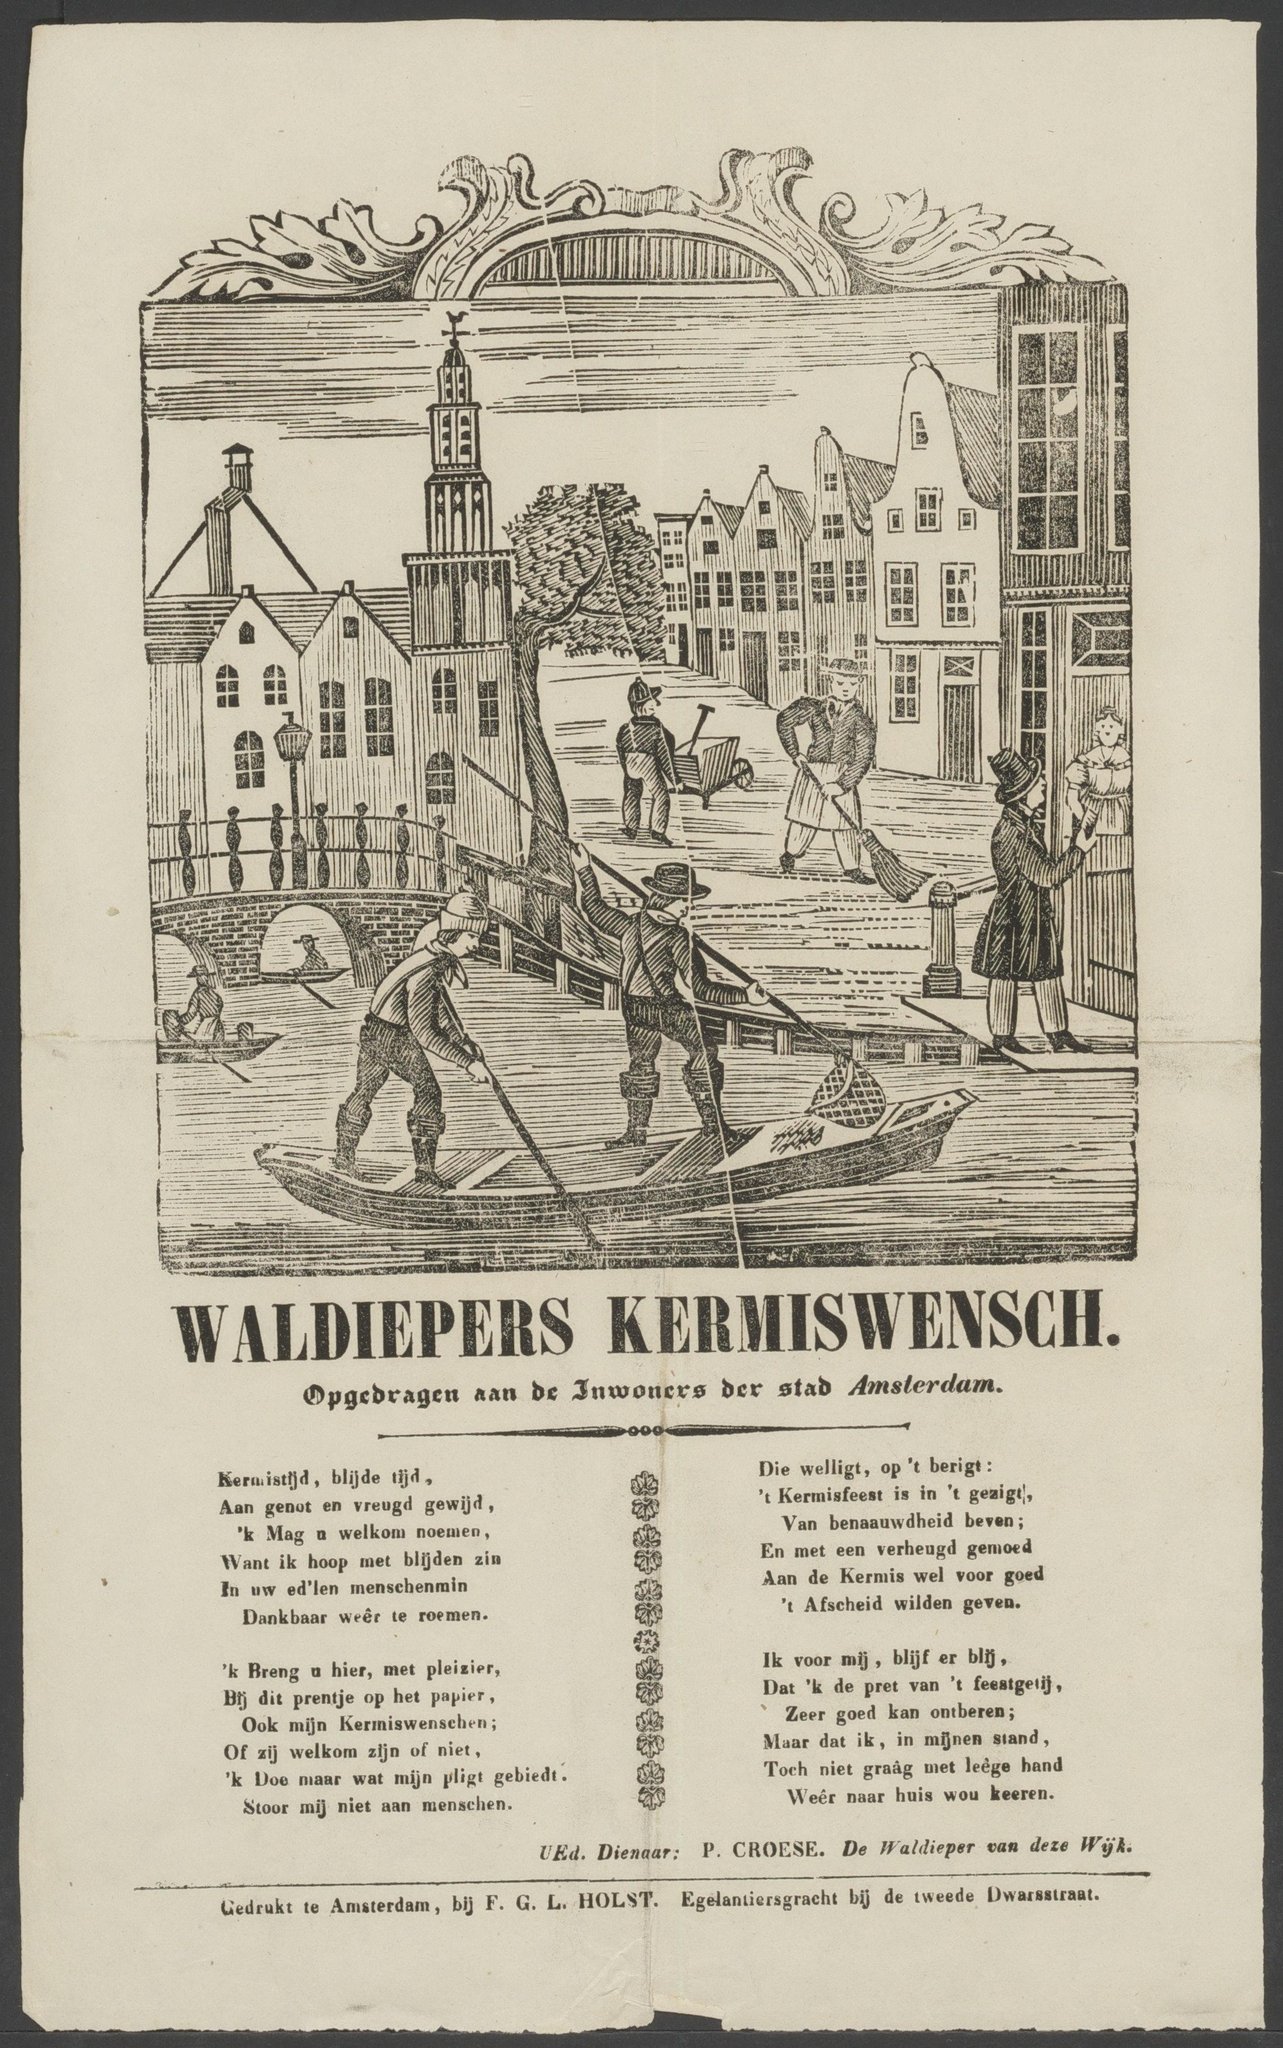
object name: new year card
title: Waldiepers Nieuwjaarswensch. Opgedragen aan heeren, kooplieden, burgers en verdere inwoners, der Stad Amsterdam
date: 1841-1864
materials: paper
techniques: letterpress printing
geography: amsterdam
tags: dredging (industrial process), canal, bridge in city across river, canal, etc., amsterdam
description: Nieuwjaarswens van de Amsterdamse waldiepers (baggeraars). Gezicht op een Amsterdamse gracht waar twee mannen in een schuit bezig zijn de gracht uit te diepen, een andere man haalt bij een huis geld op. Met een vers in twee kolommen. Namens de waldieper P. Croese. Onderwerpsrubrieken binnen de Atlas Zeden en Gewoonten: Zeden en gewoonten in engeren zin, Volksleven, Volksbladen, Nieuwjaars- en Kerstwenschen, Amsterdam.